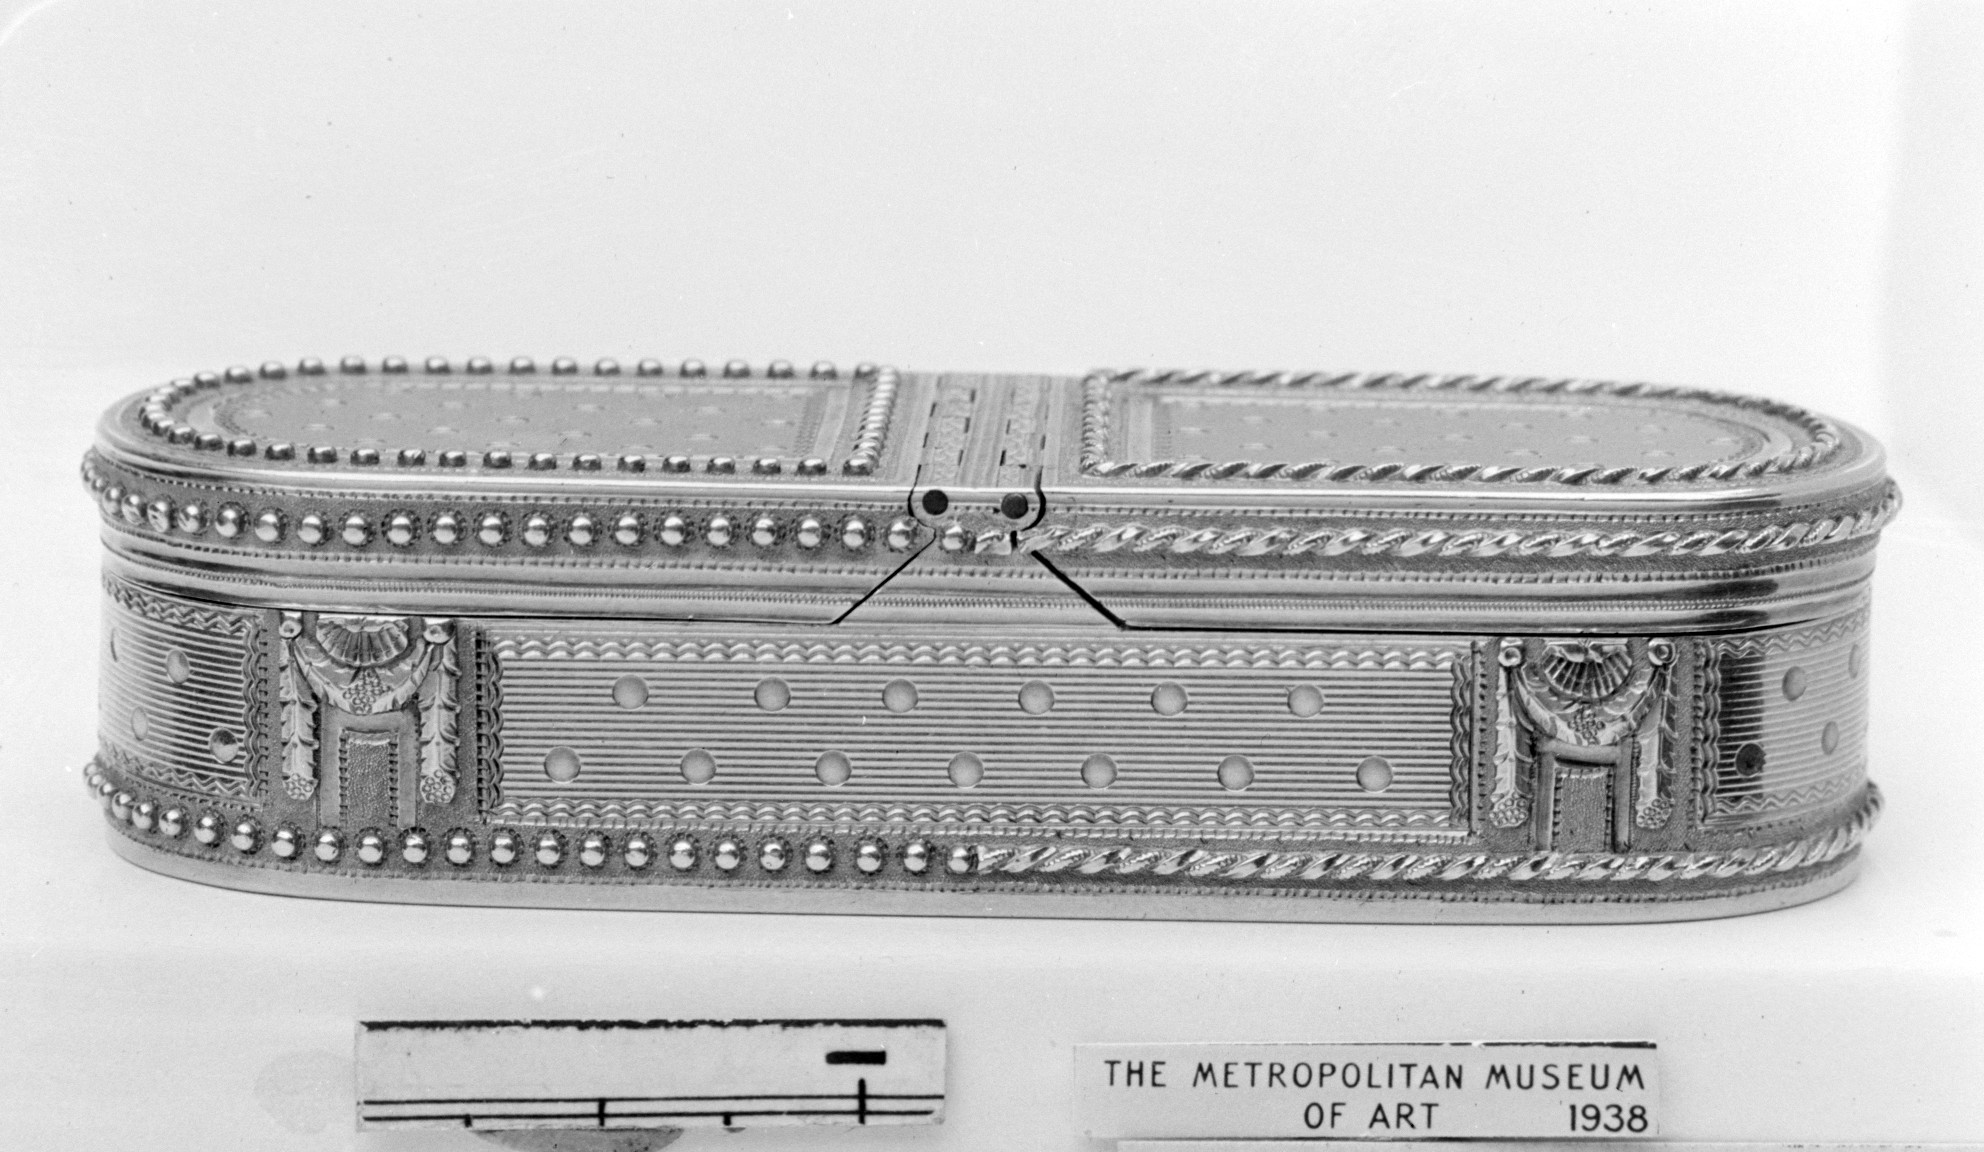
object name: box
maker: nicolas-jean-baptiste choconain-delauney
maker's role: maker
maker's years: 1775-1793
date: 1782-1783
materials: gold